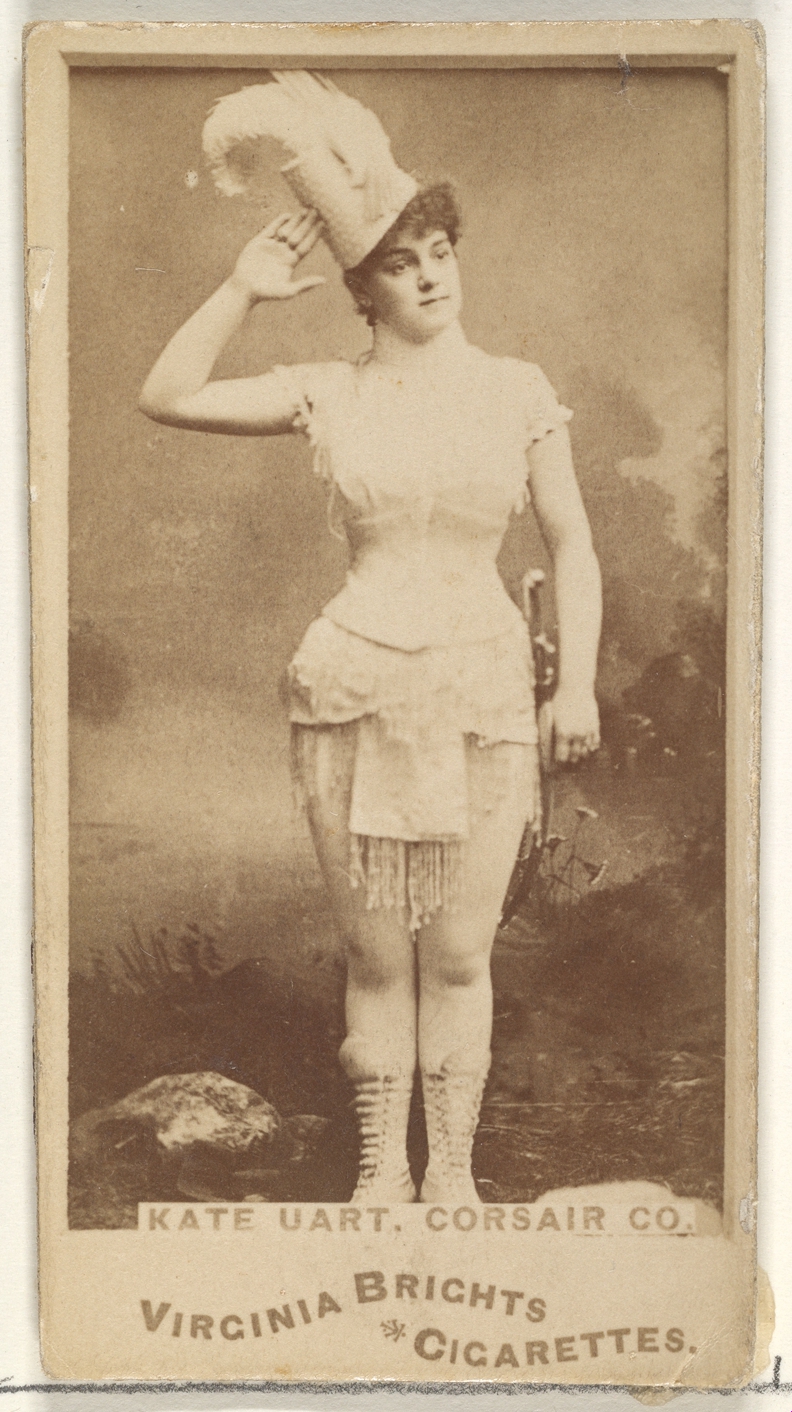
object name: photograph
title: Kate Uart, Corsair Co., from the Actors and Actresses series (N45, Type 1) for Virginia Brights Cigarettes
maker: allen & ginter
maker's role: publisher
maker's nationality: american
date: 1888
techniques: albumen silver print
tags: portraits,women,actresses